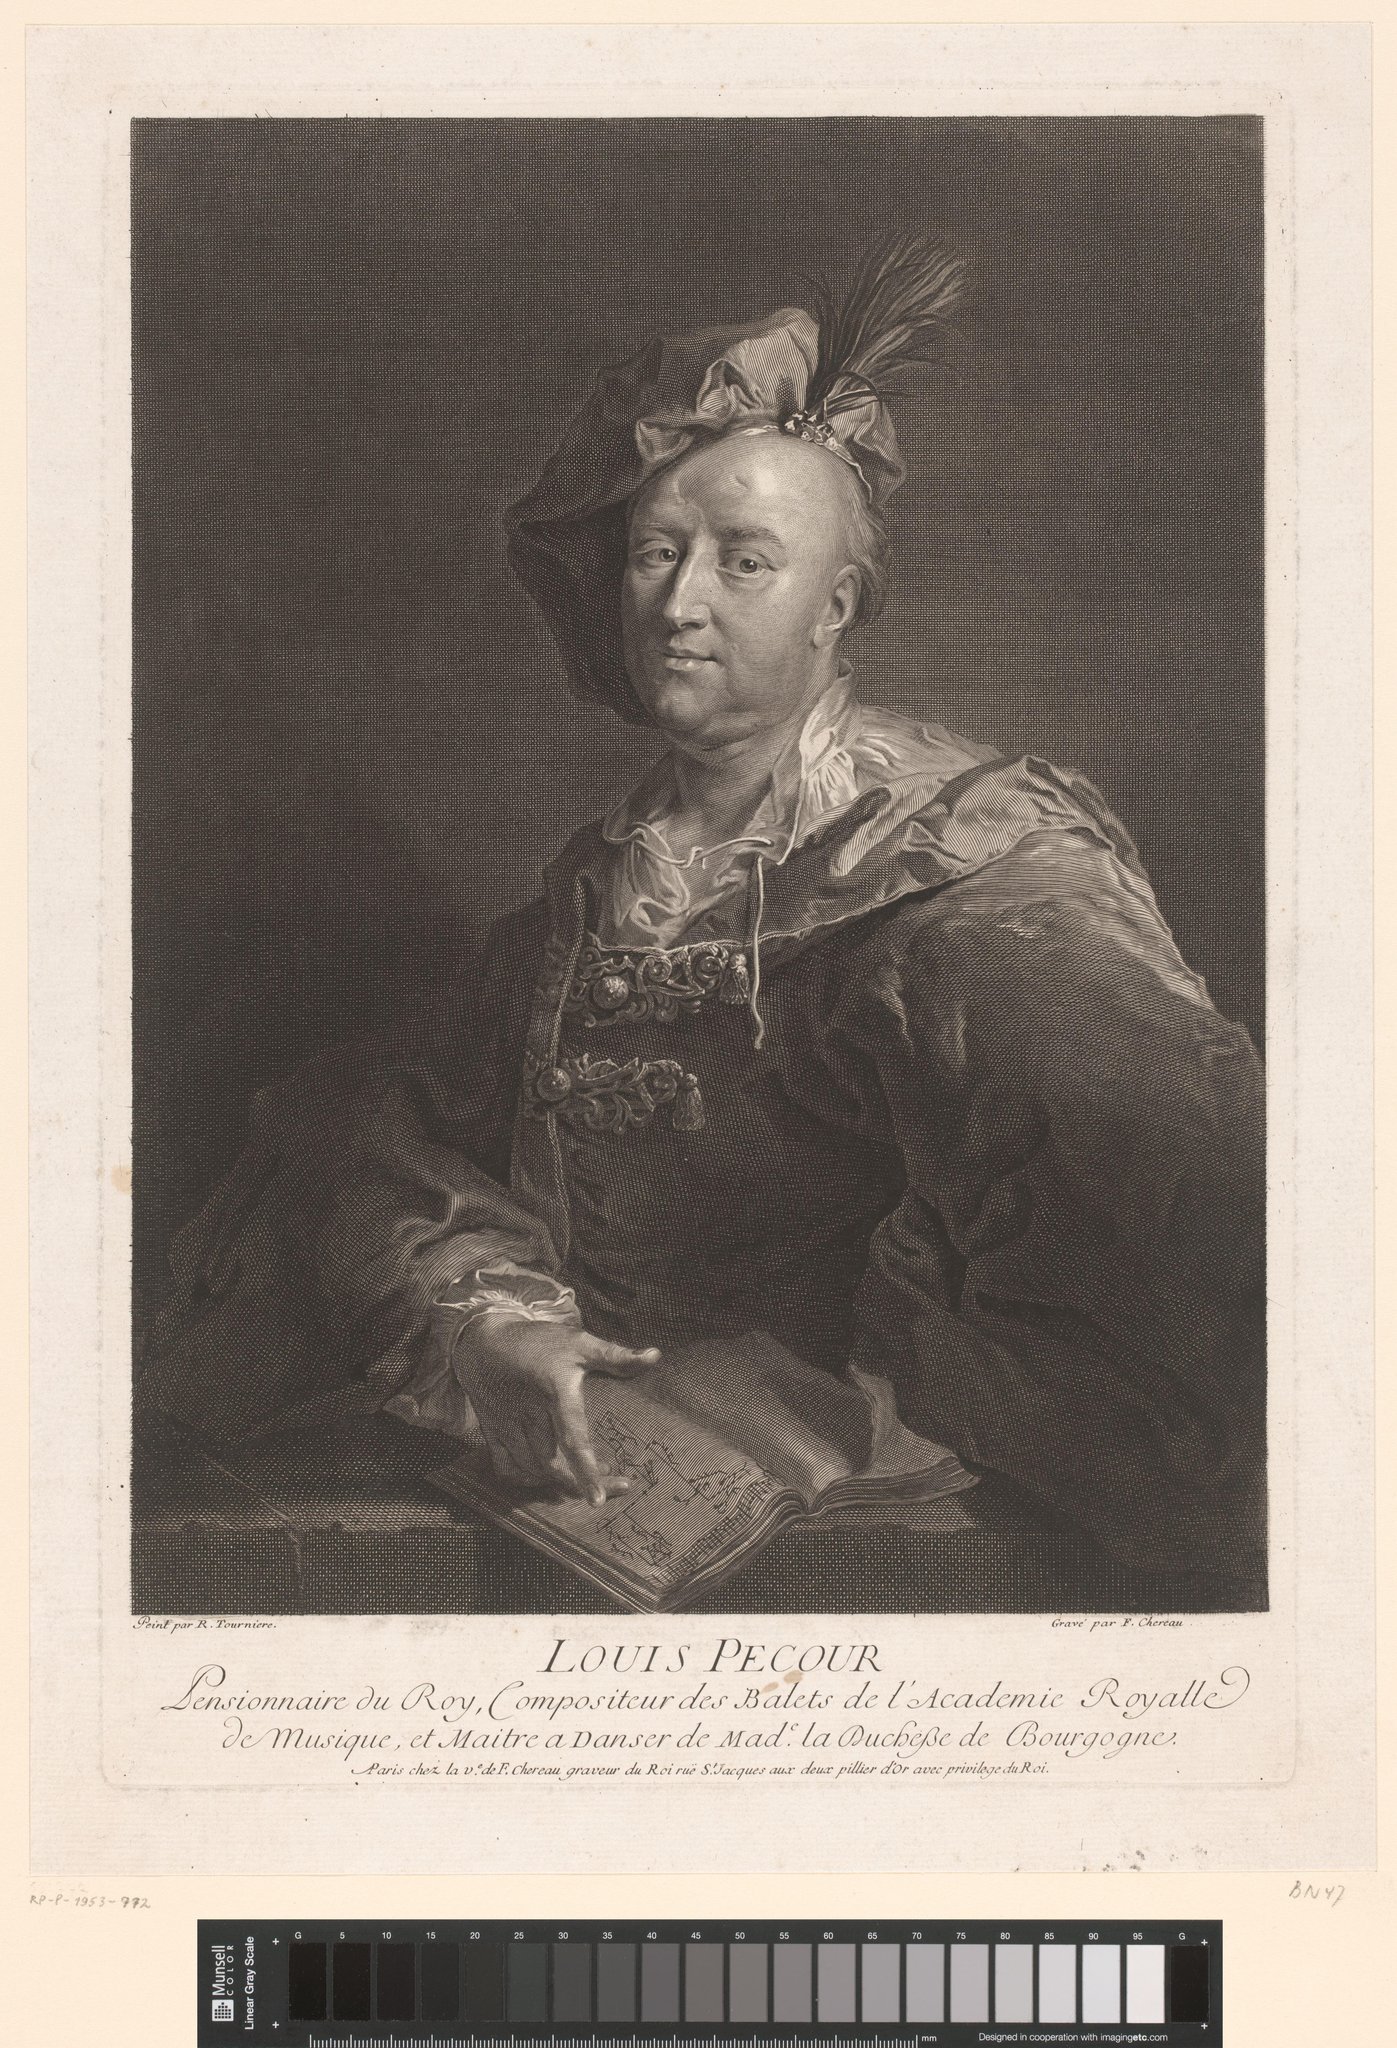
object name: print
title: Portret van Louis-Guillaume Pécour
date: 1690-1729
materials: paper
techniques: engraving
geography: paris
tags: paris, book, portrait of dancer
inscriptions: collector's mark: Lugt 2228, collector's mark: Lugt 2760